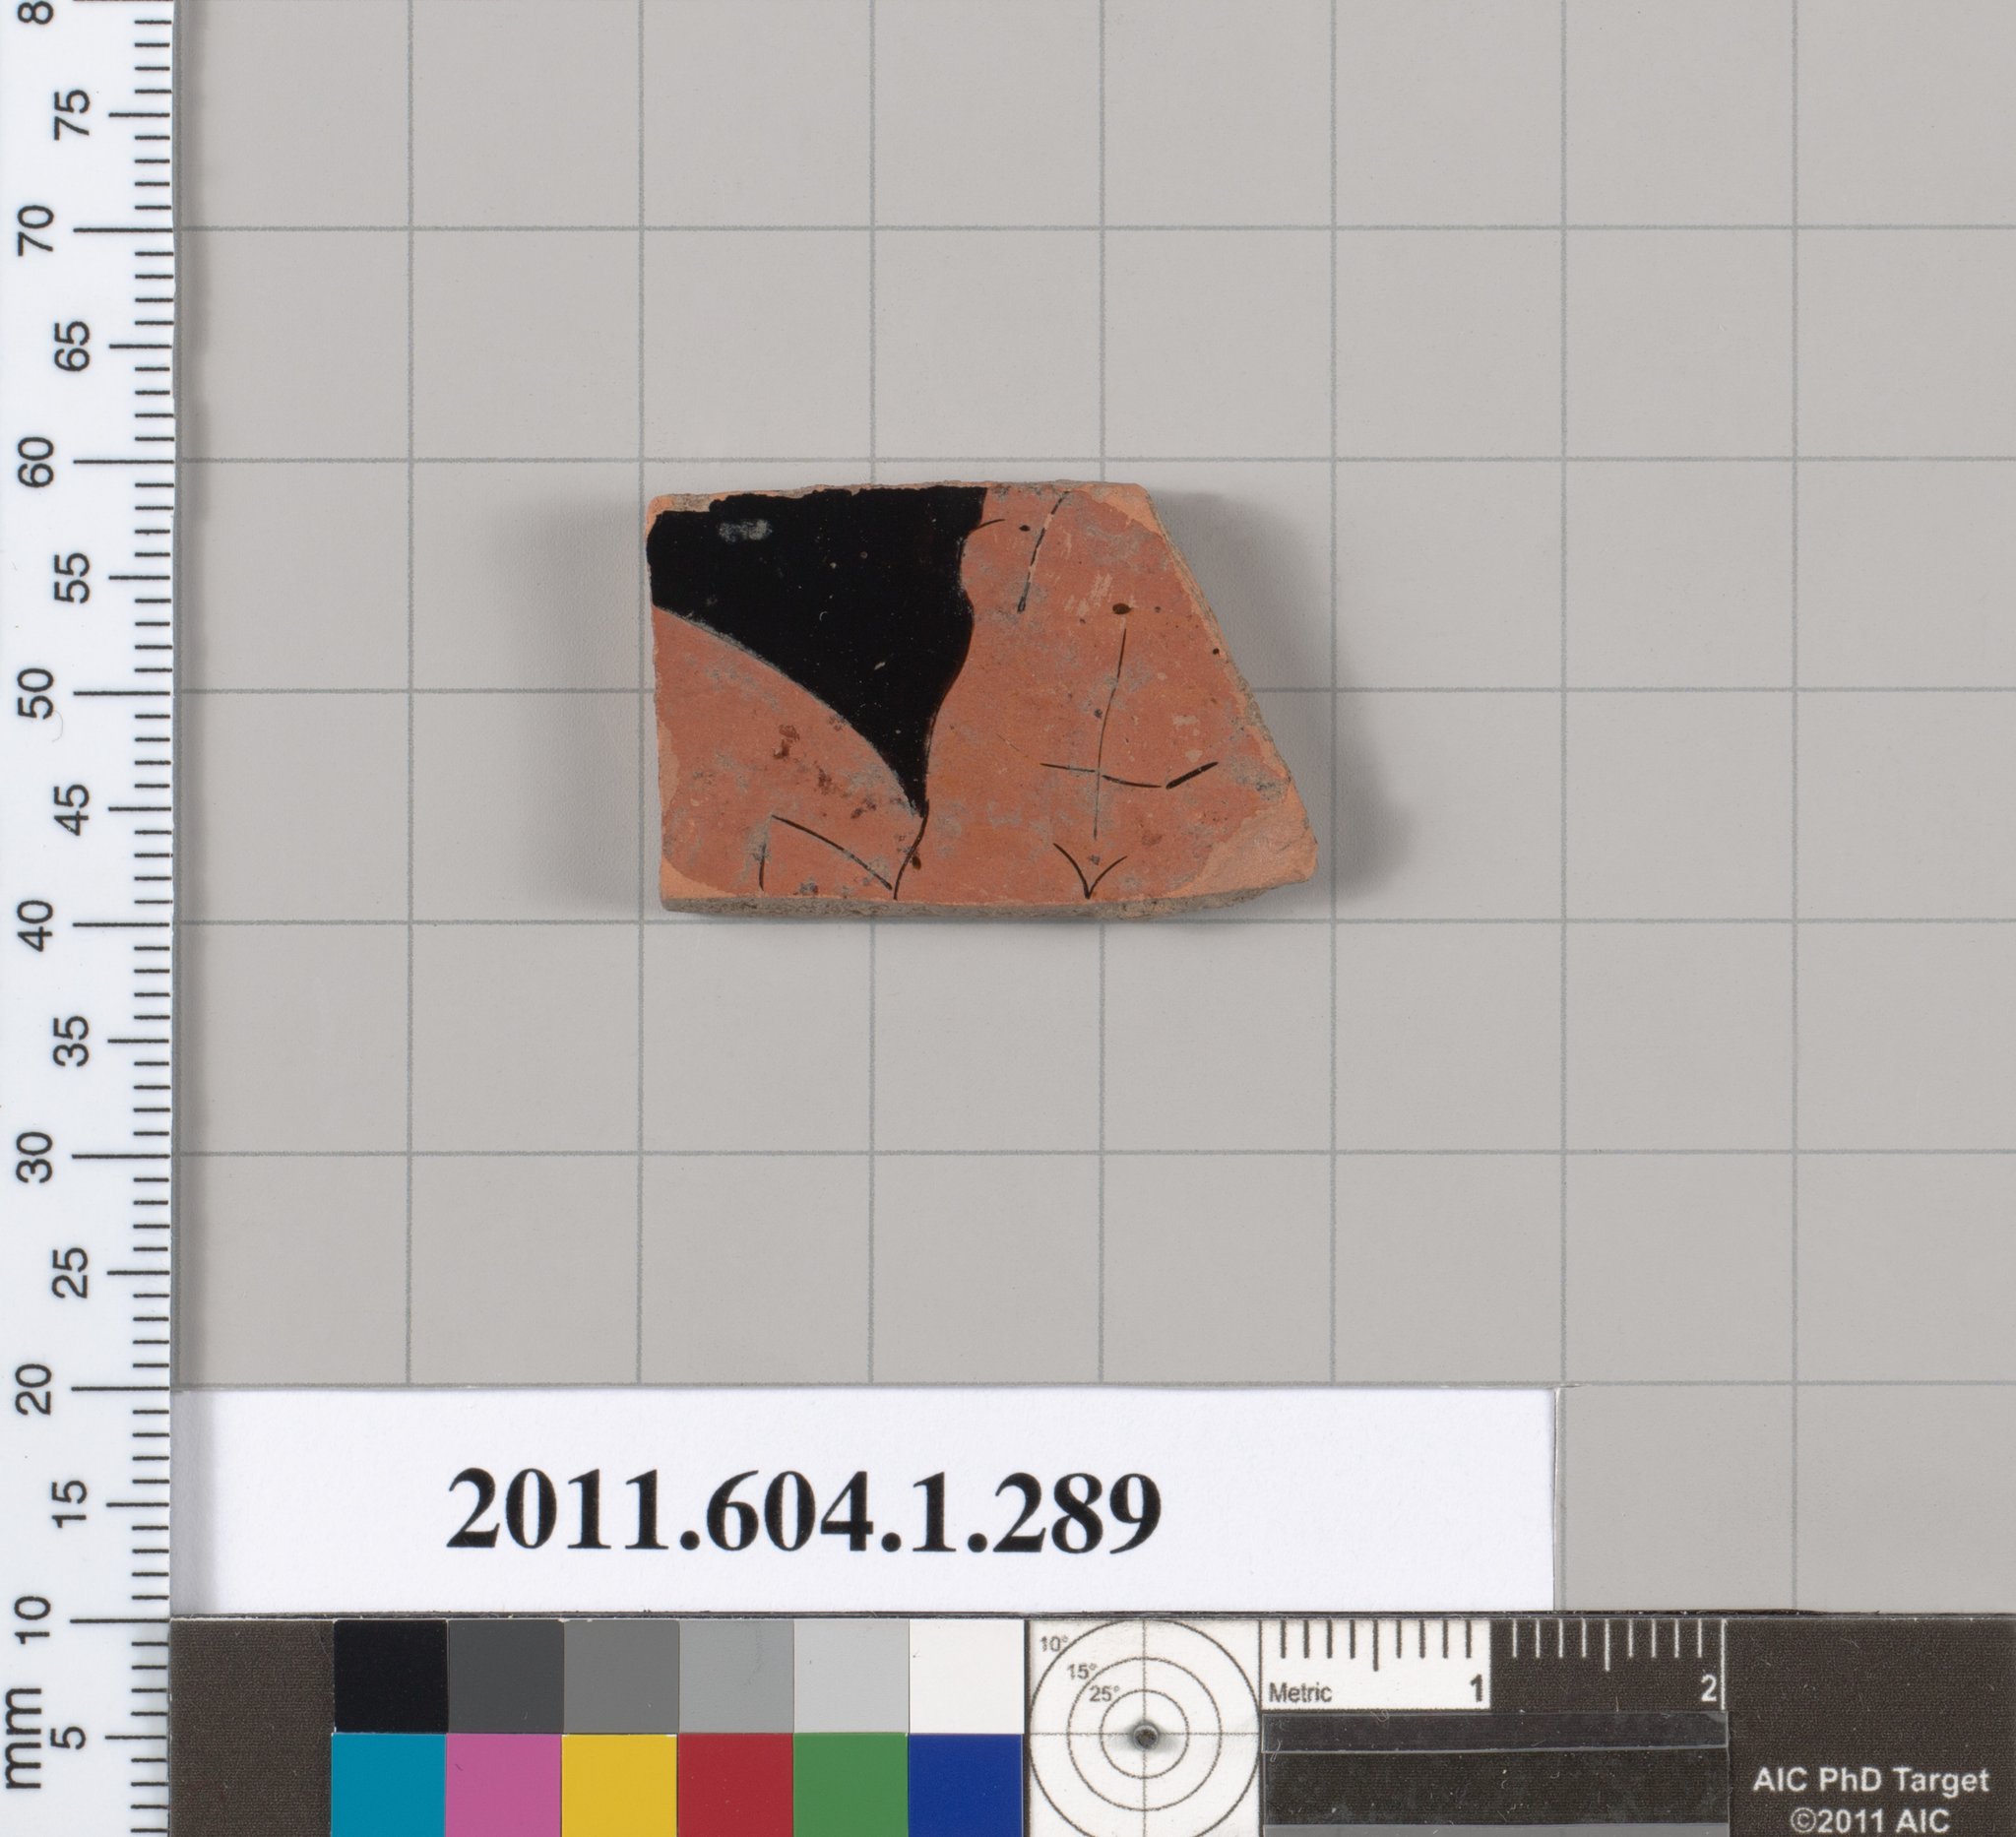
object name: kylix fragment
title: Terracotta fragment of a kylix (drinking cup)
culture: greek, attic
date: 475-451 BCE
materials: terracotta